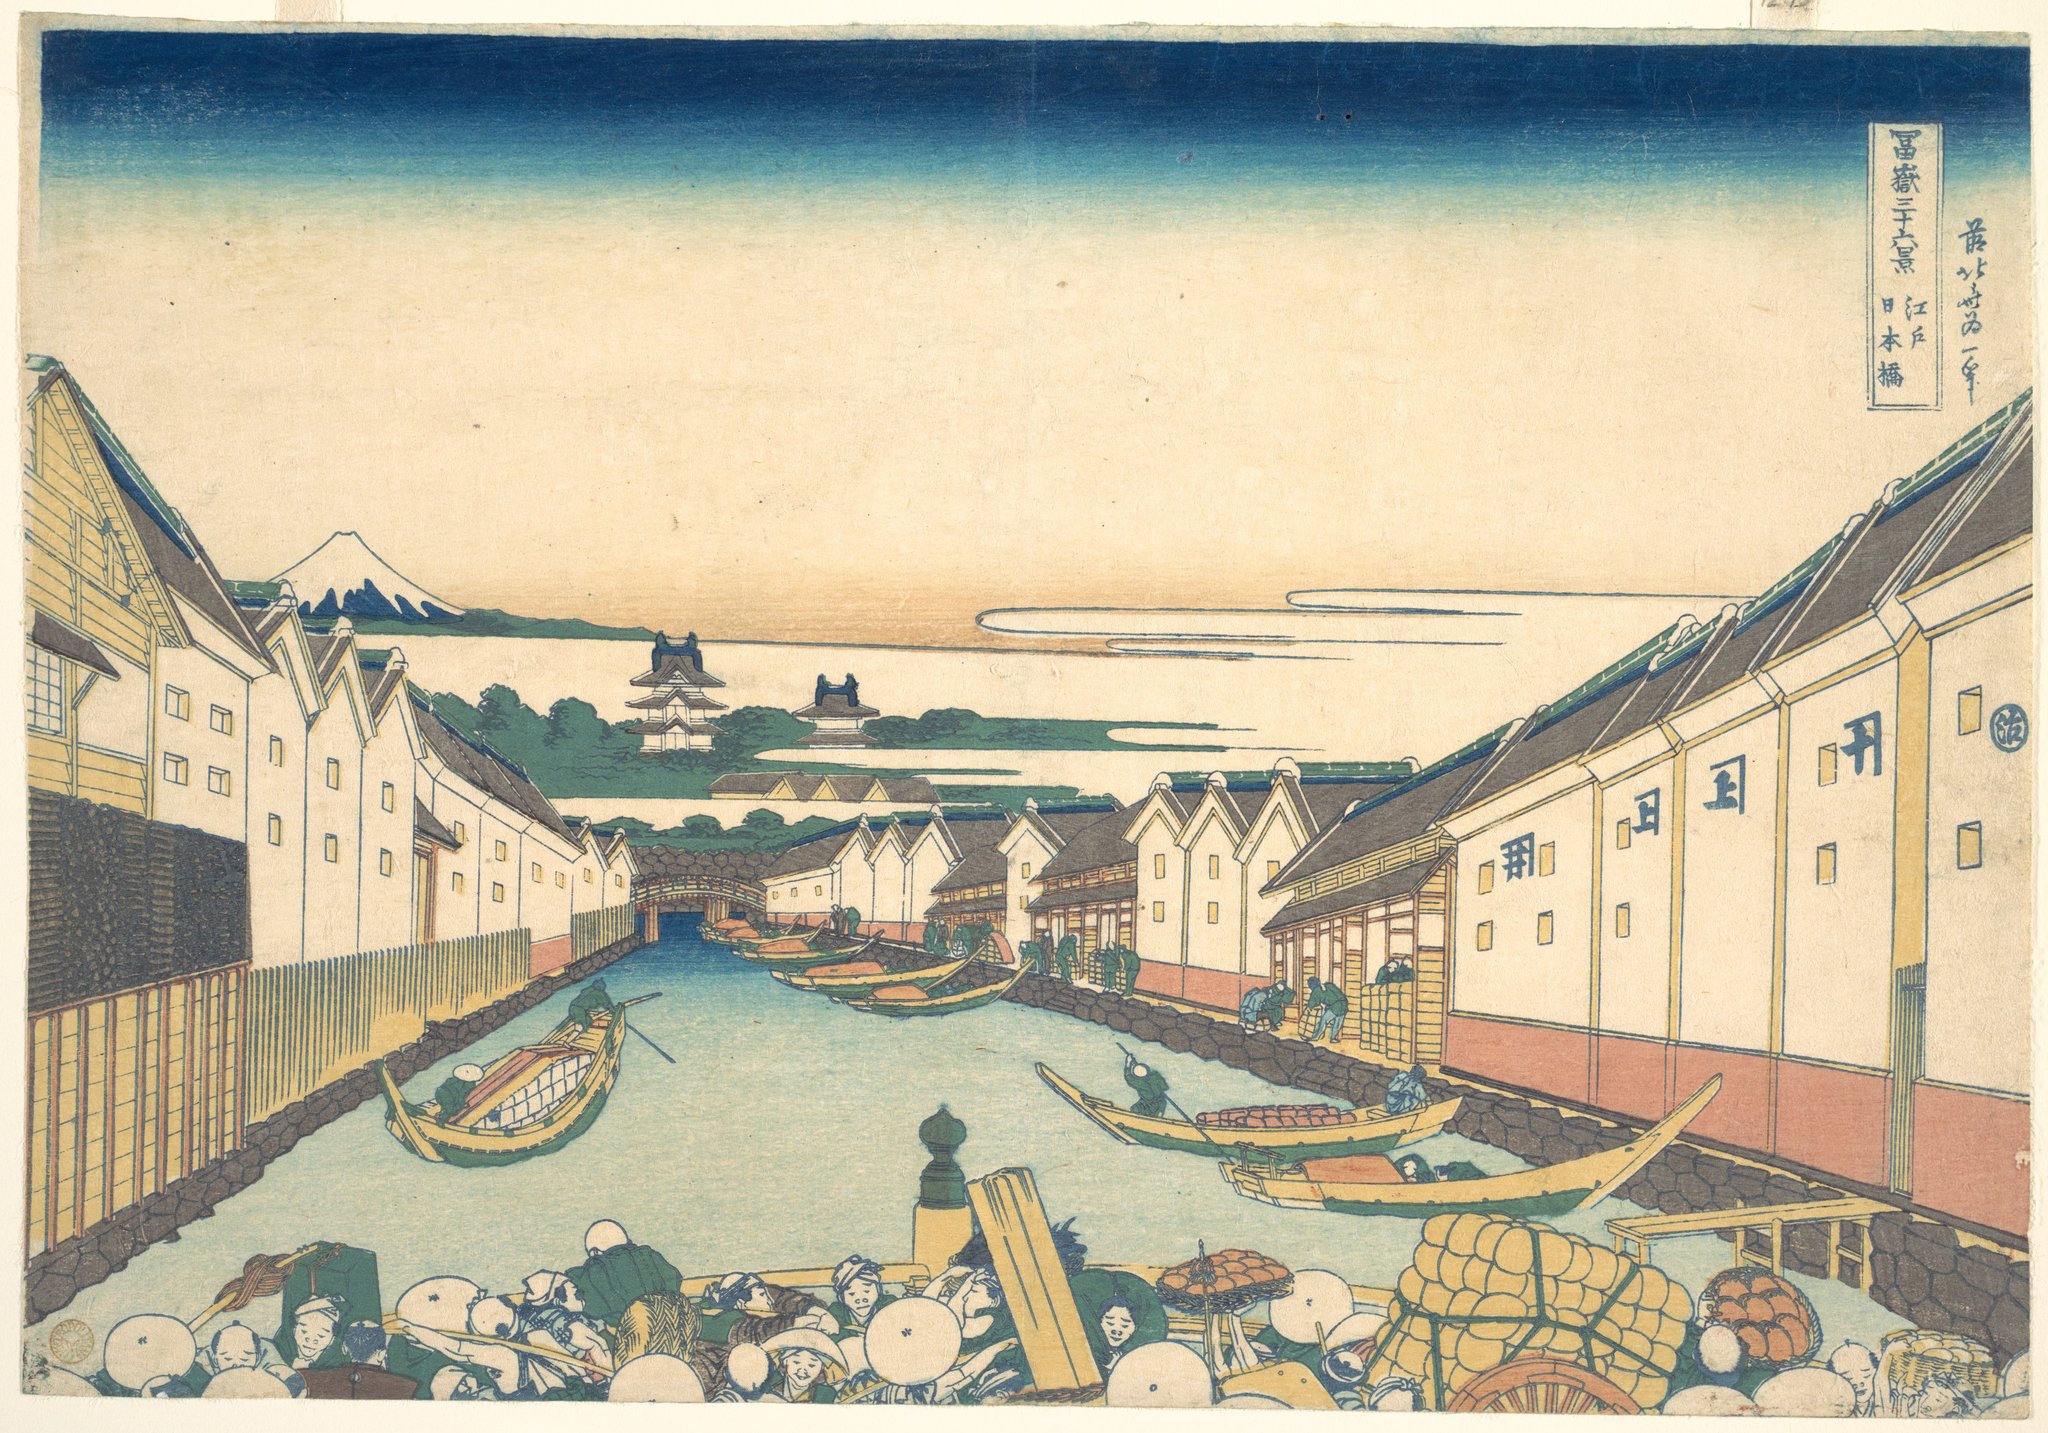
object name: woodblock print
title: Nihonbashi in Edo (Edo Nihonbashi), from the series Thirty-six Views of Mount Fuji (Fugaku sanjūrokkei)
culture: japanese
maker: katsushika hokusai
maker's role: artist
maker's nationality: japanese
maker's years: 1760-1849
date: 1830-1832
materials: ink, paper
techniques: woodblock print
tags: buildings,canals,boats